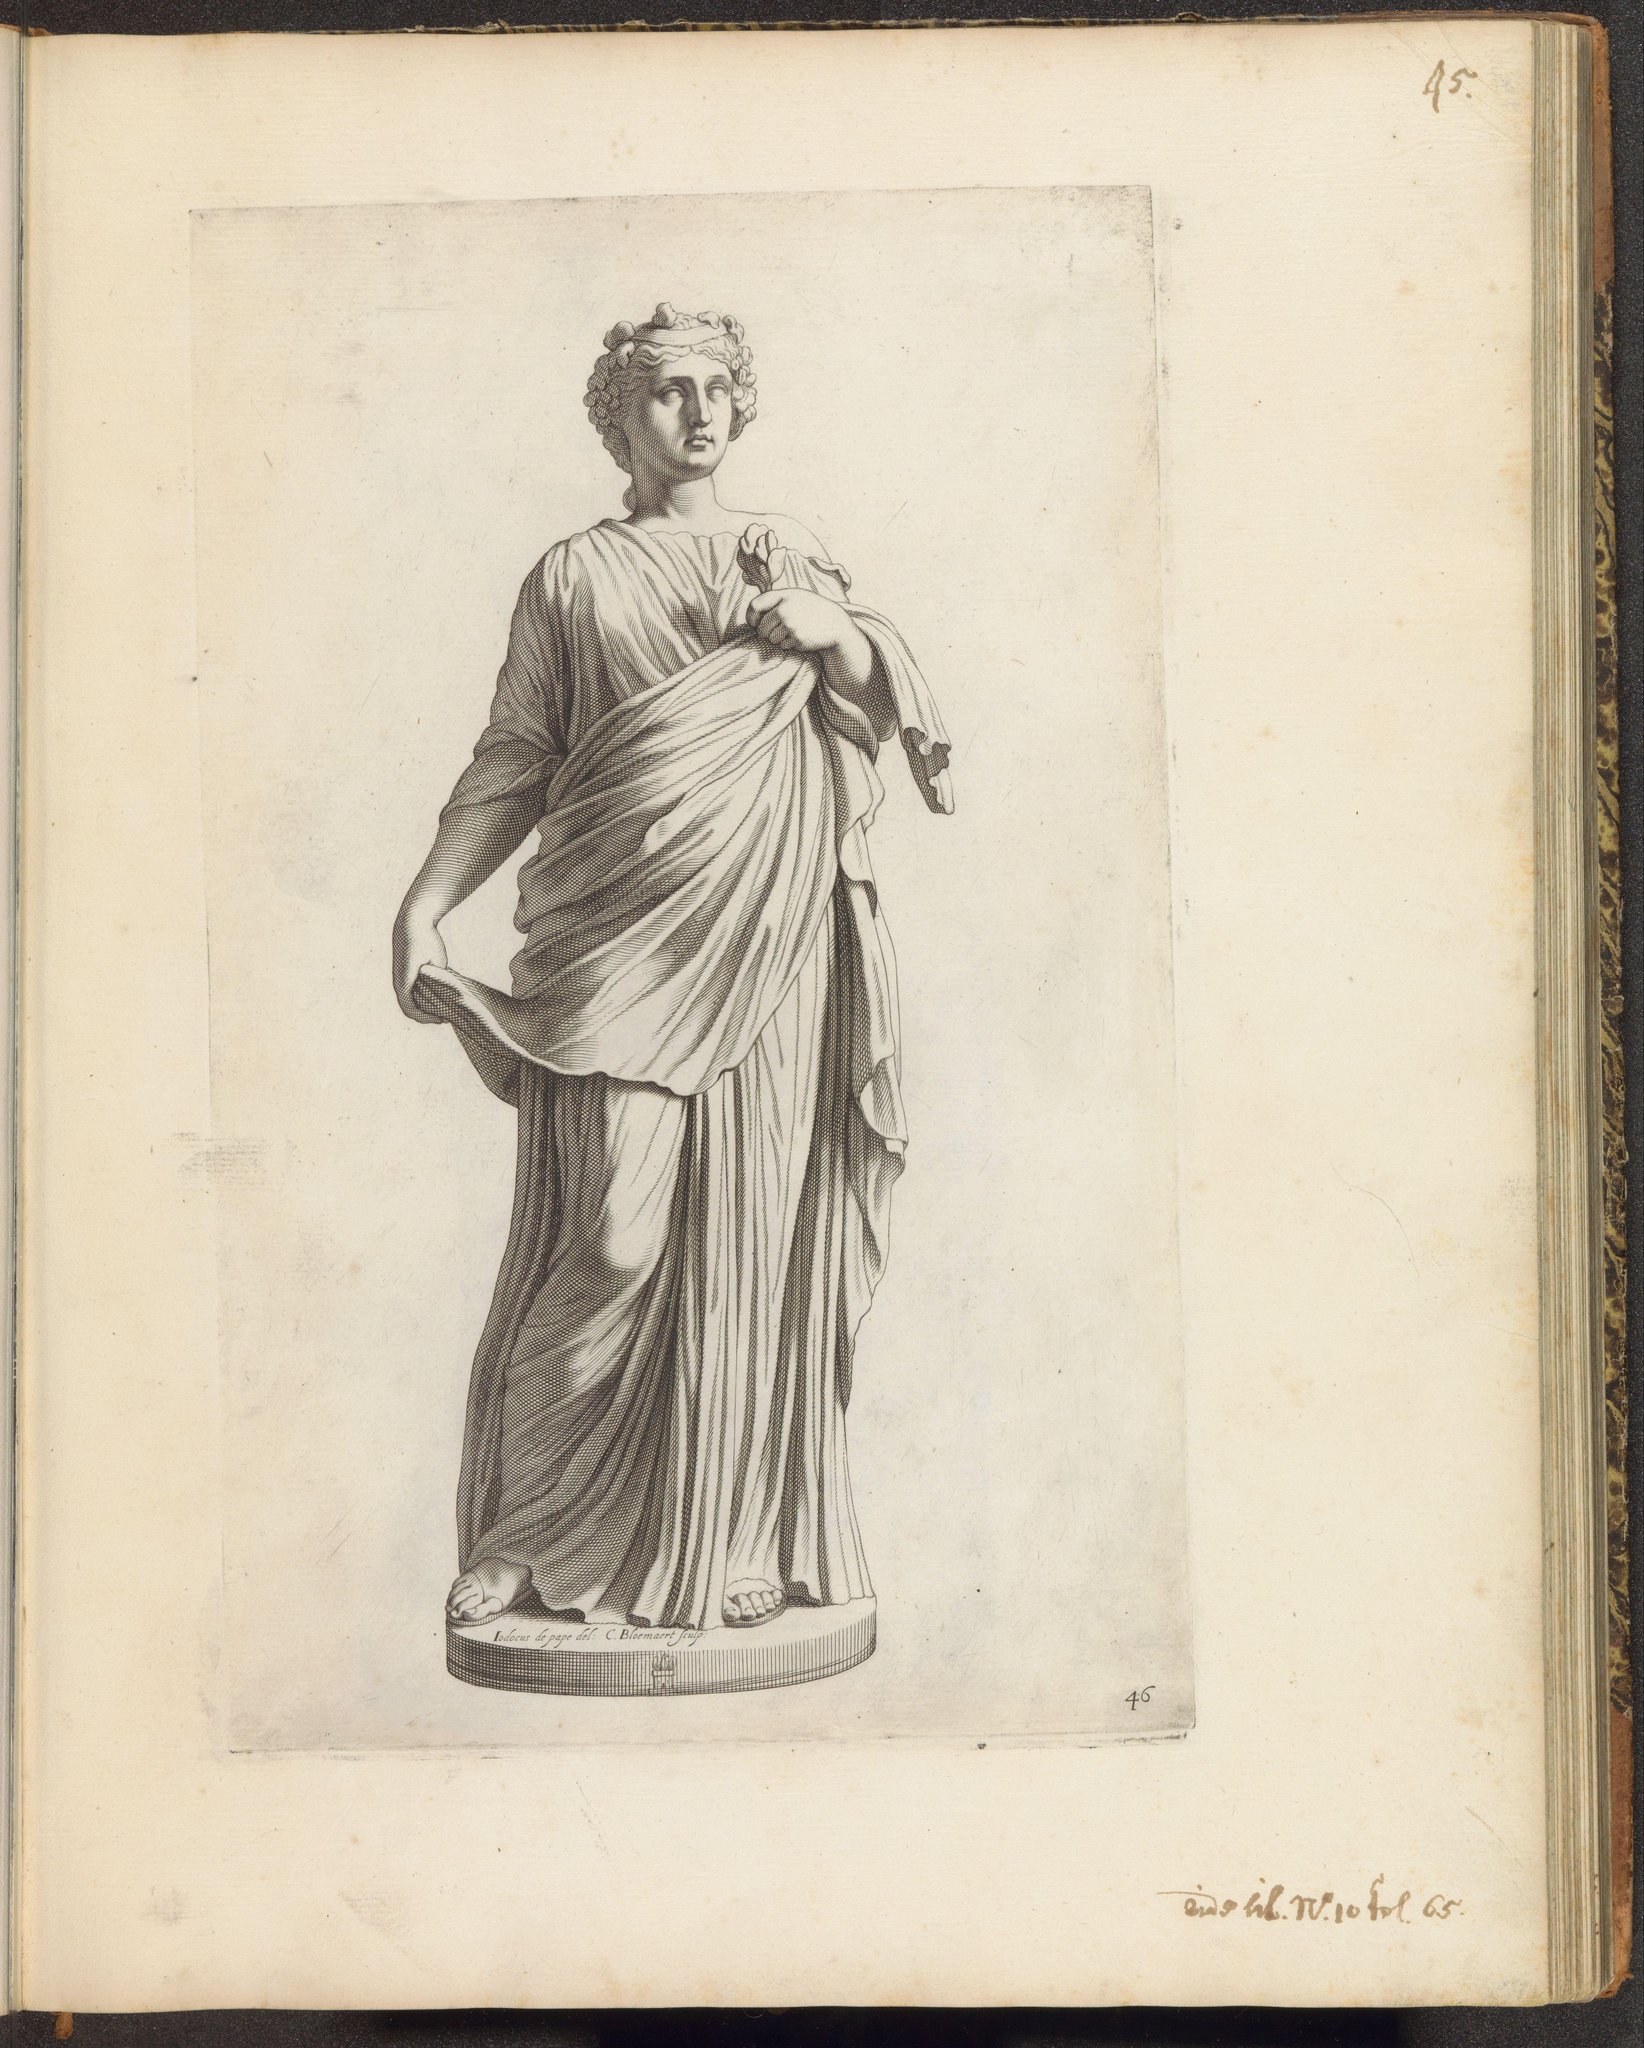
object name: album leaf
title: Standbeeld van vrouw met bloem in haar hand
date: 1636-1647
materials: paper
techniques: engraving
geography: rome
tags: piece of sculpture, reproduction of a piece of sculpture, female persons from classical history (+ full length)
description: Beeld van een vrouw in Romeinse kleding. In haar linkerhand houdt zij een bloem. Op de basis het wapenschild van Vincenzo Giustiniani. Prent maakt deel uit van een album met een serie prenten naar de sculpturen in de verzameling in de Galleria Giustiniani te Rome.